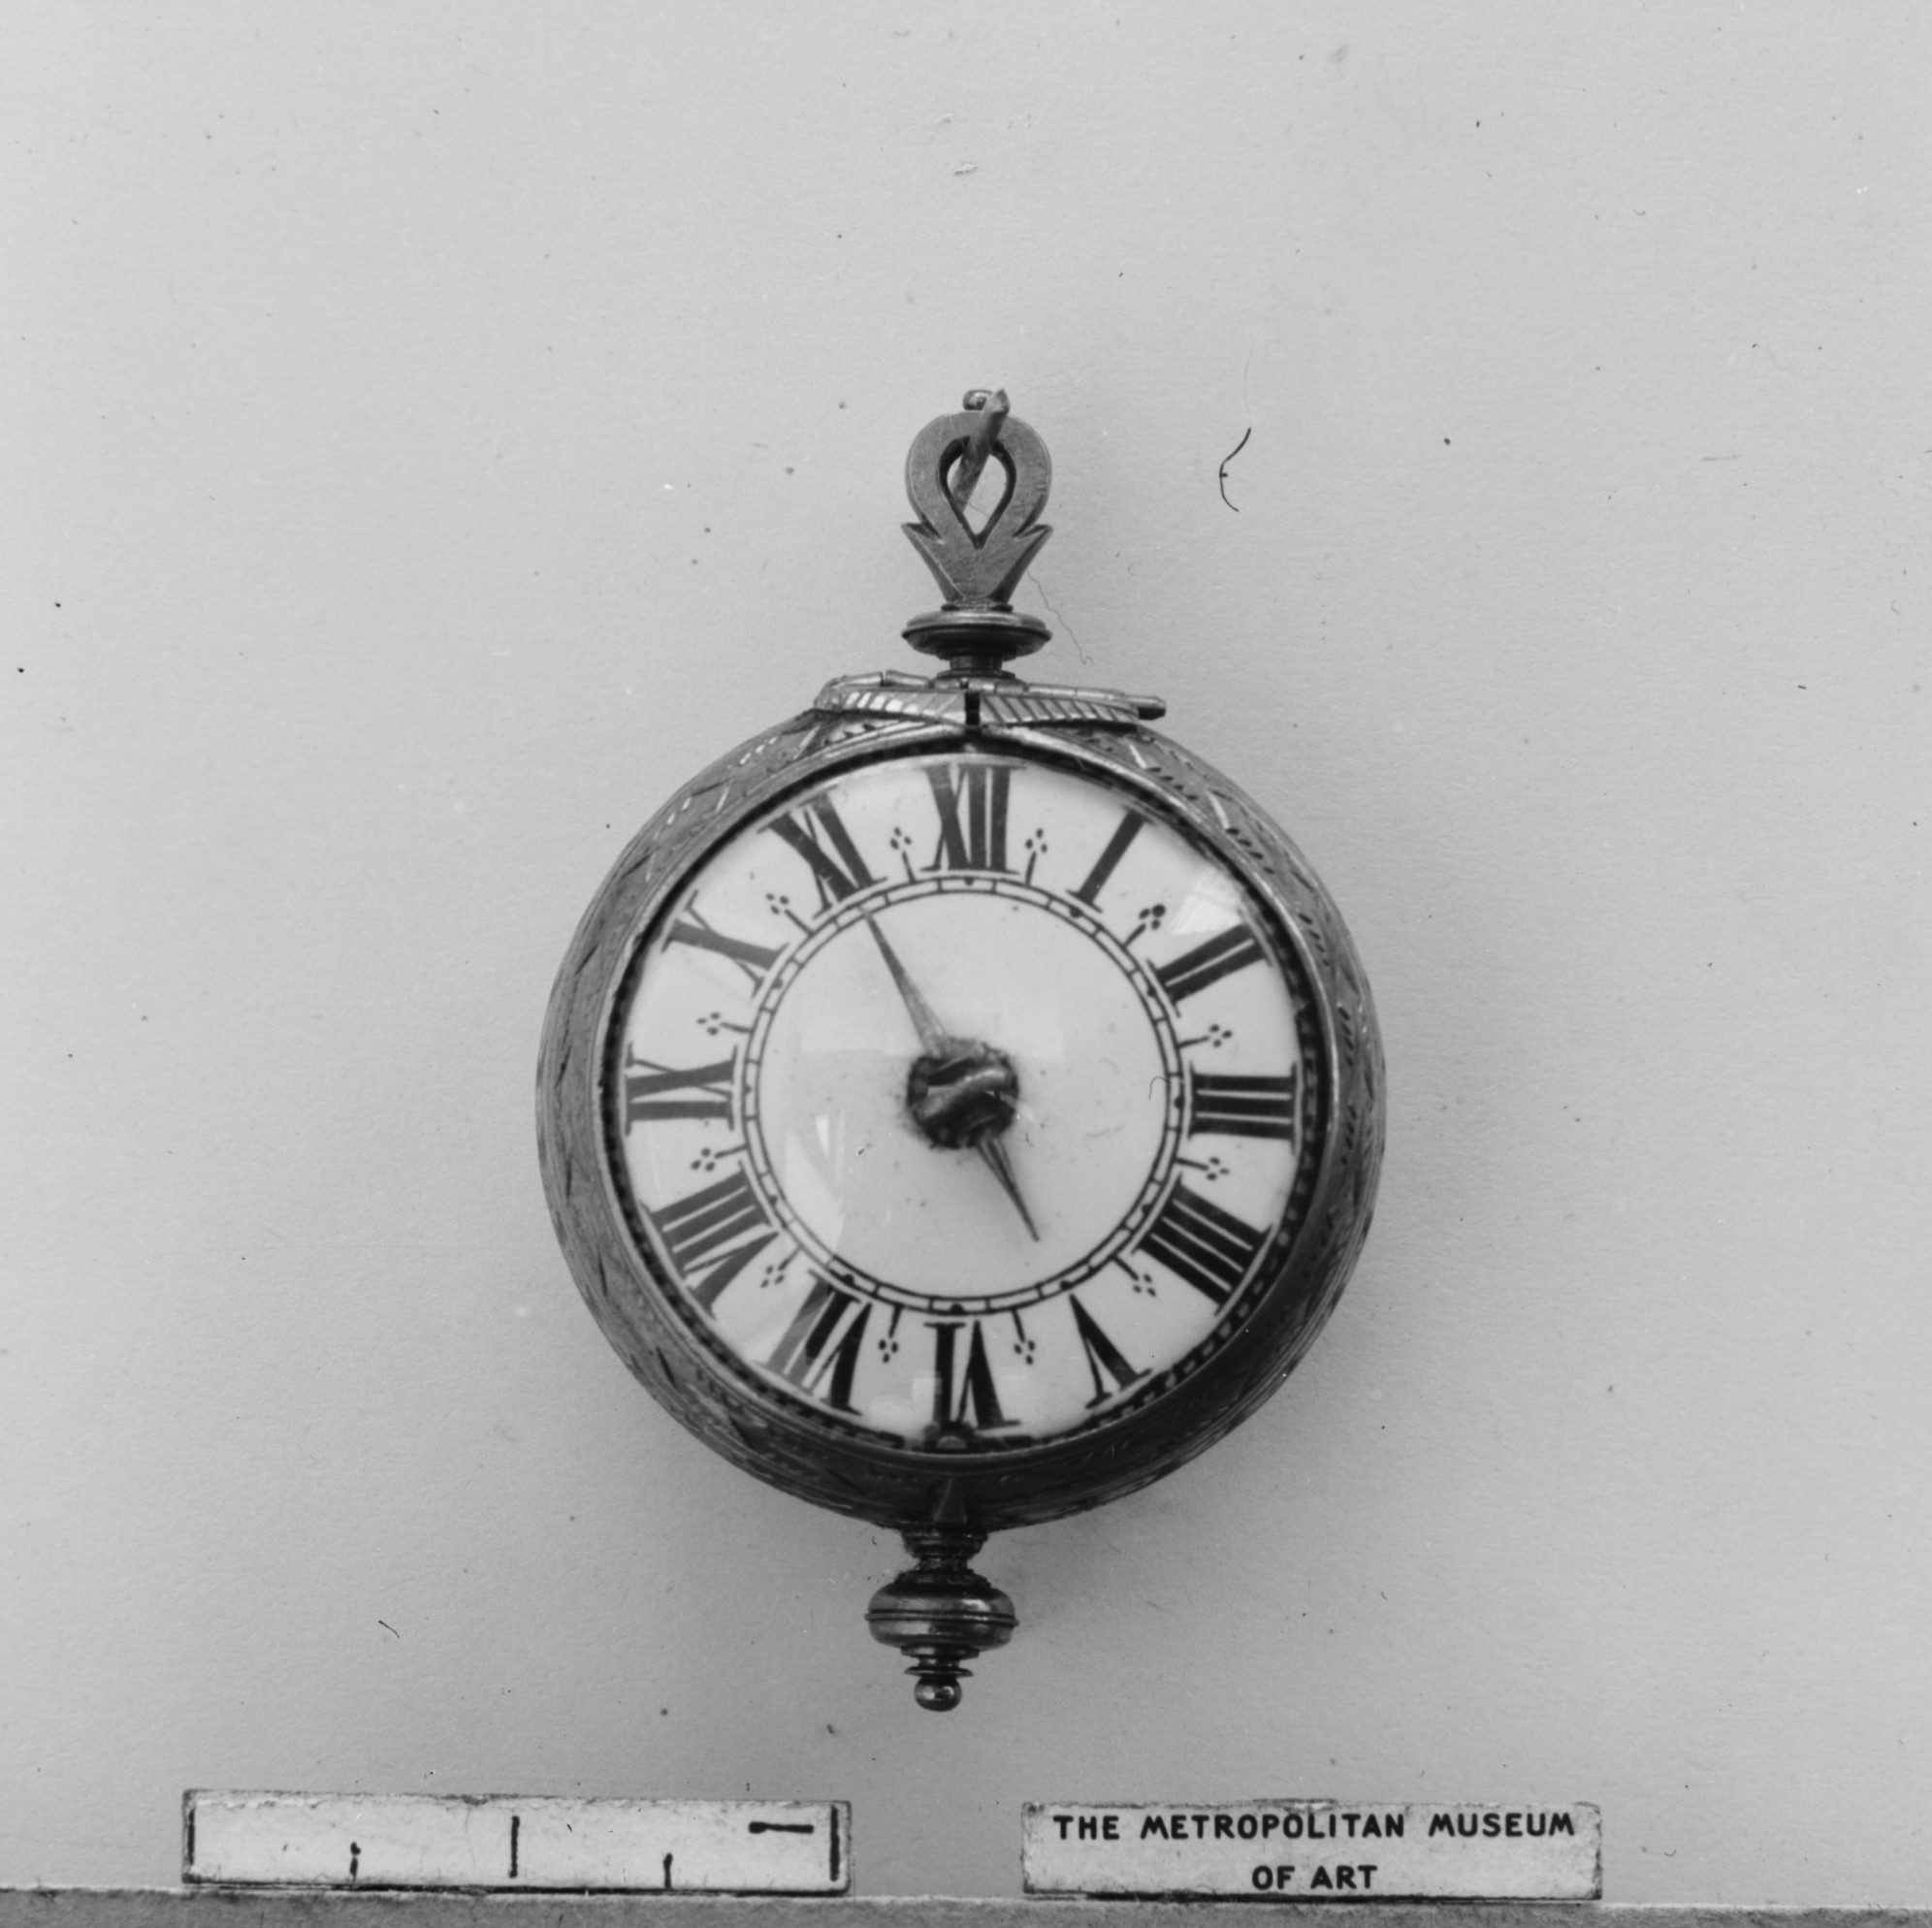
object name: watch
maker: abraham yver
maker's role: maker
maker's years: 1620-1680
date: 1601-1700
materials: enamel, metal